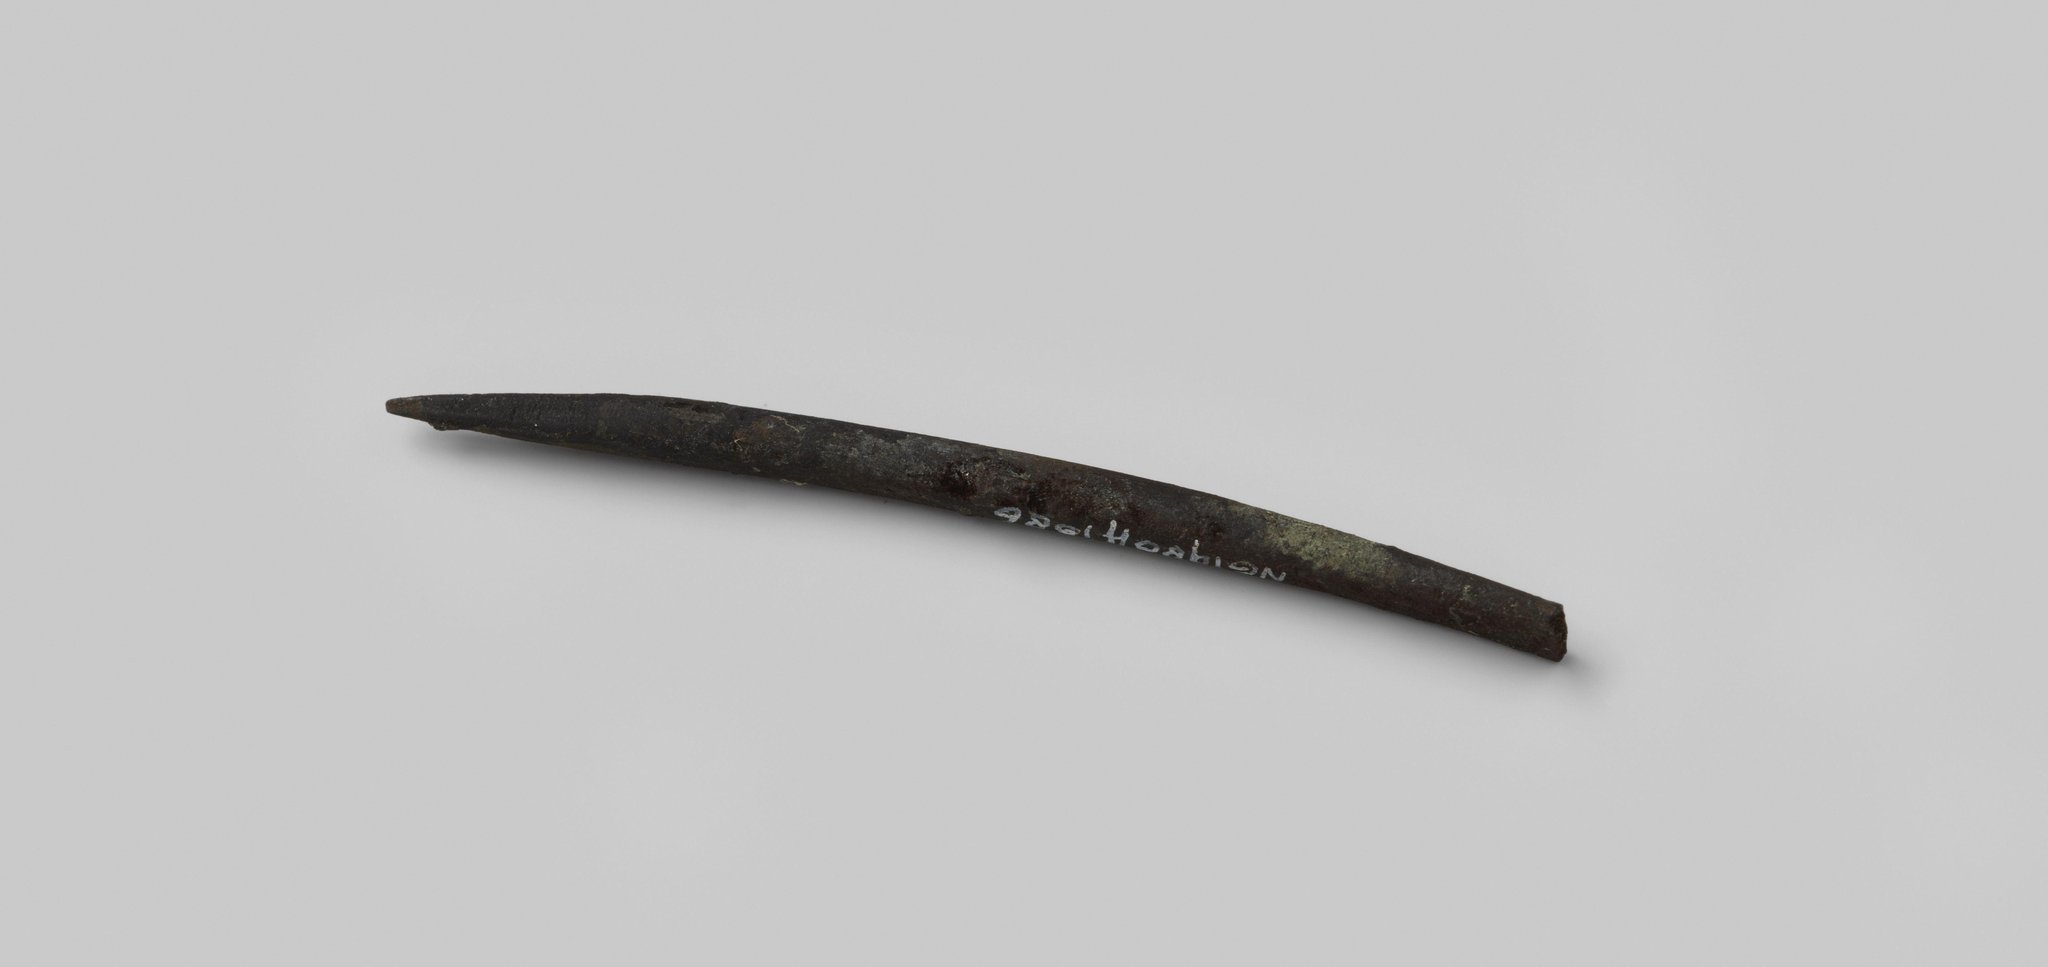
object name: fragment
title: Gepunt onderdeel uit het wrak van de Oost-Indiëvaarder Hollandia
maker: Anonymous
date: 1700-1743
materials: copper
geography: netherlands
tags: verenigde oostindische compagnie, hollandia (schip), annet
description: Varied parts or fragments, points or pointed end fragments; fragm, sim. 80H535, broken end flat, slightly curved.